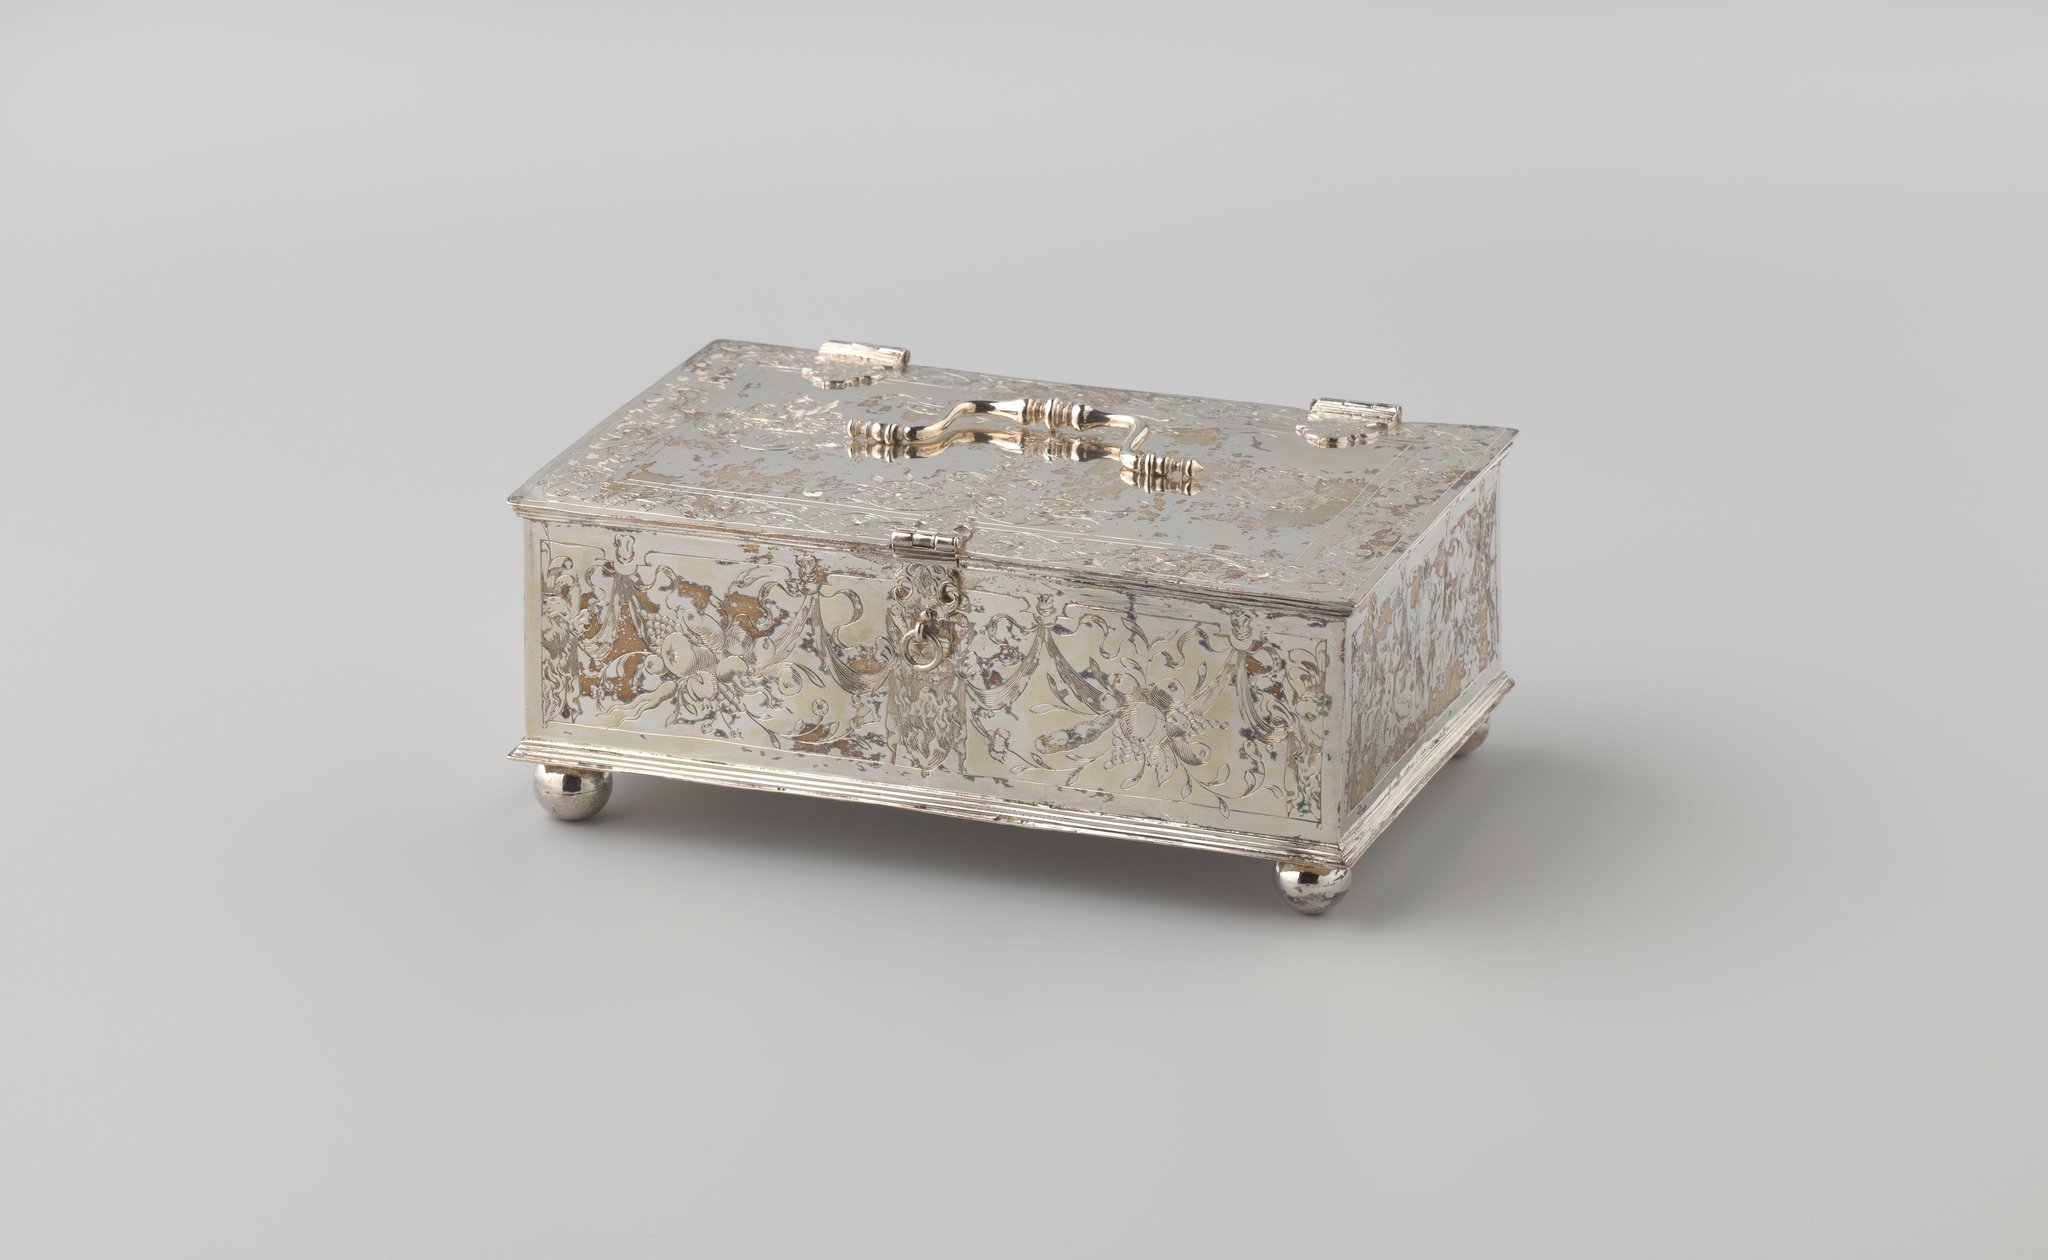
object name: kruidendoos, specerijdoos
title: Box with coat of arms of Frans Meerman and Maria Ysbrandtsdr De Bije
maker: jan gerritsz oosterlingh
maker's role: silversmith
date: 1616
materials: silver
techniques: casting, engraving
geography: the hague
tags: fruits, foliage, tendrils, branches ~ ornament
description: Spice box. Silver. The Hague, 1616, by Jan Gerrits Oosterlingh. On loan from the governors of Deutzenhofje in Amsterdam.